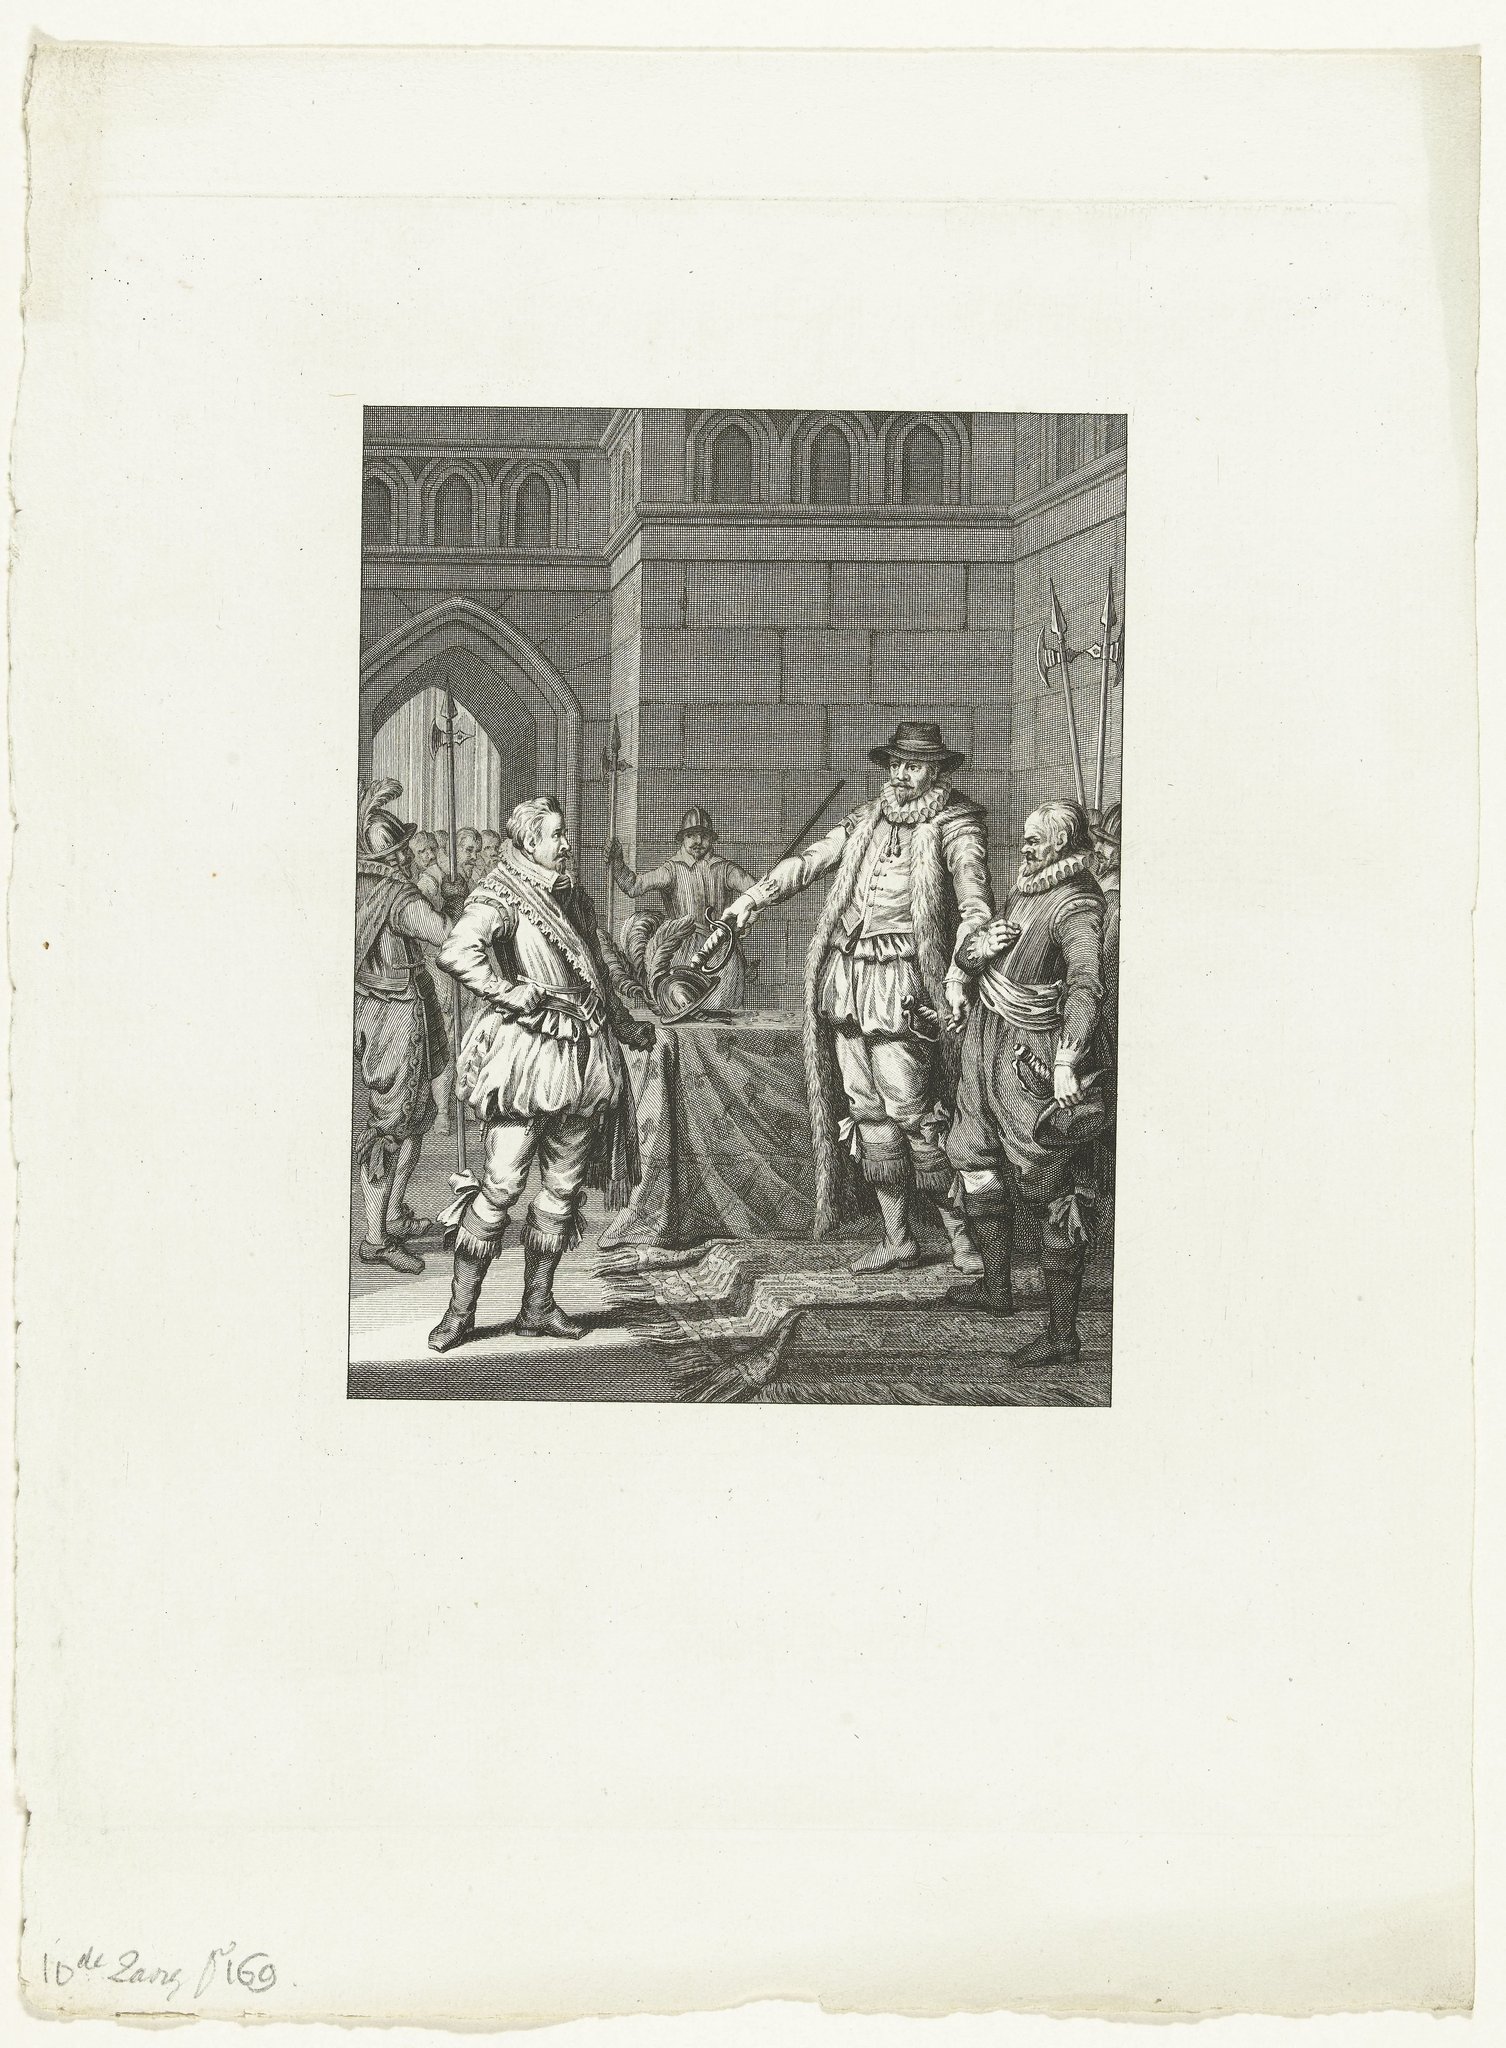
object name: print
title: Oranje geeft Bossu te Hoorn zijn zwaard terug, 1573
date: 1781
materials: paper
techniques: etching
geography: amsterdam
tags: delft, william i (prince of orange), antwerp, earl, hoorn (north holland)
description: Illustratie voor: J. Nomsz, Willem de eerste, of de grondlegging der Nederlandsche vryheid. : In vier en twintig zangen, Erven van David Klippink, Amsterdam 1779. Staat vóór de letter. Groep van vier proefdrukken in de oorspronkelijke omslag van de uitgevers J. Smit en Zoon en W. Vermandel te Amsterdam, 1781 (de derde uitgave).